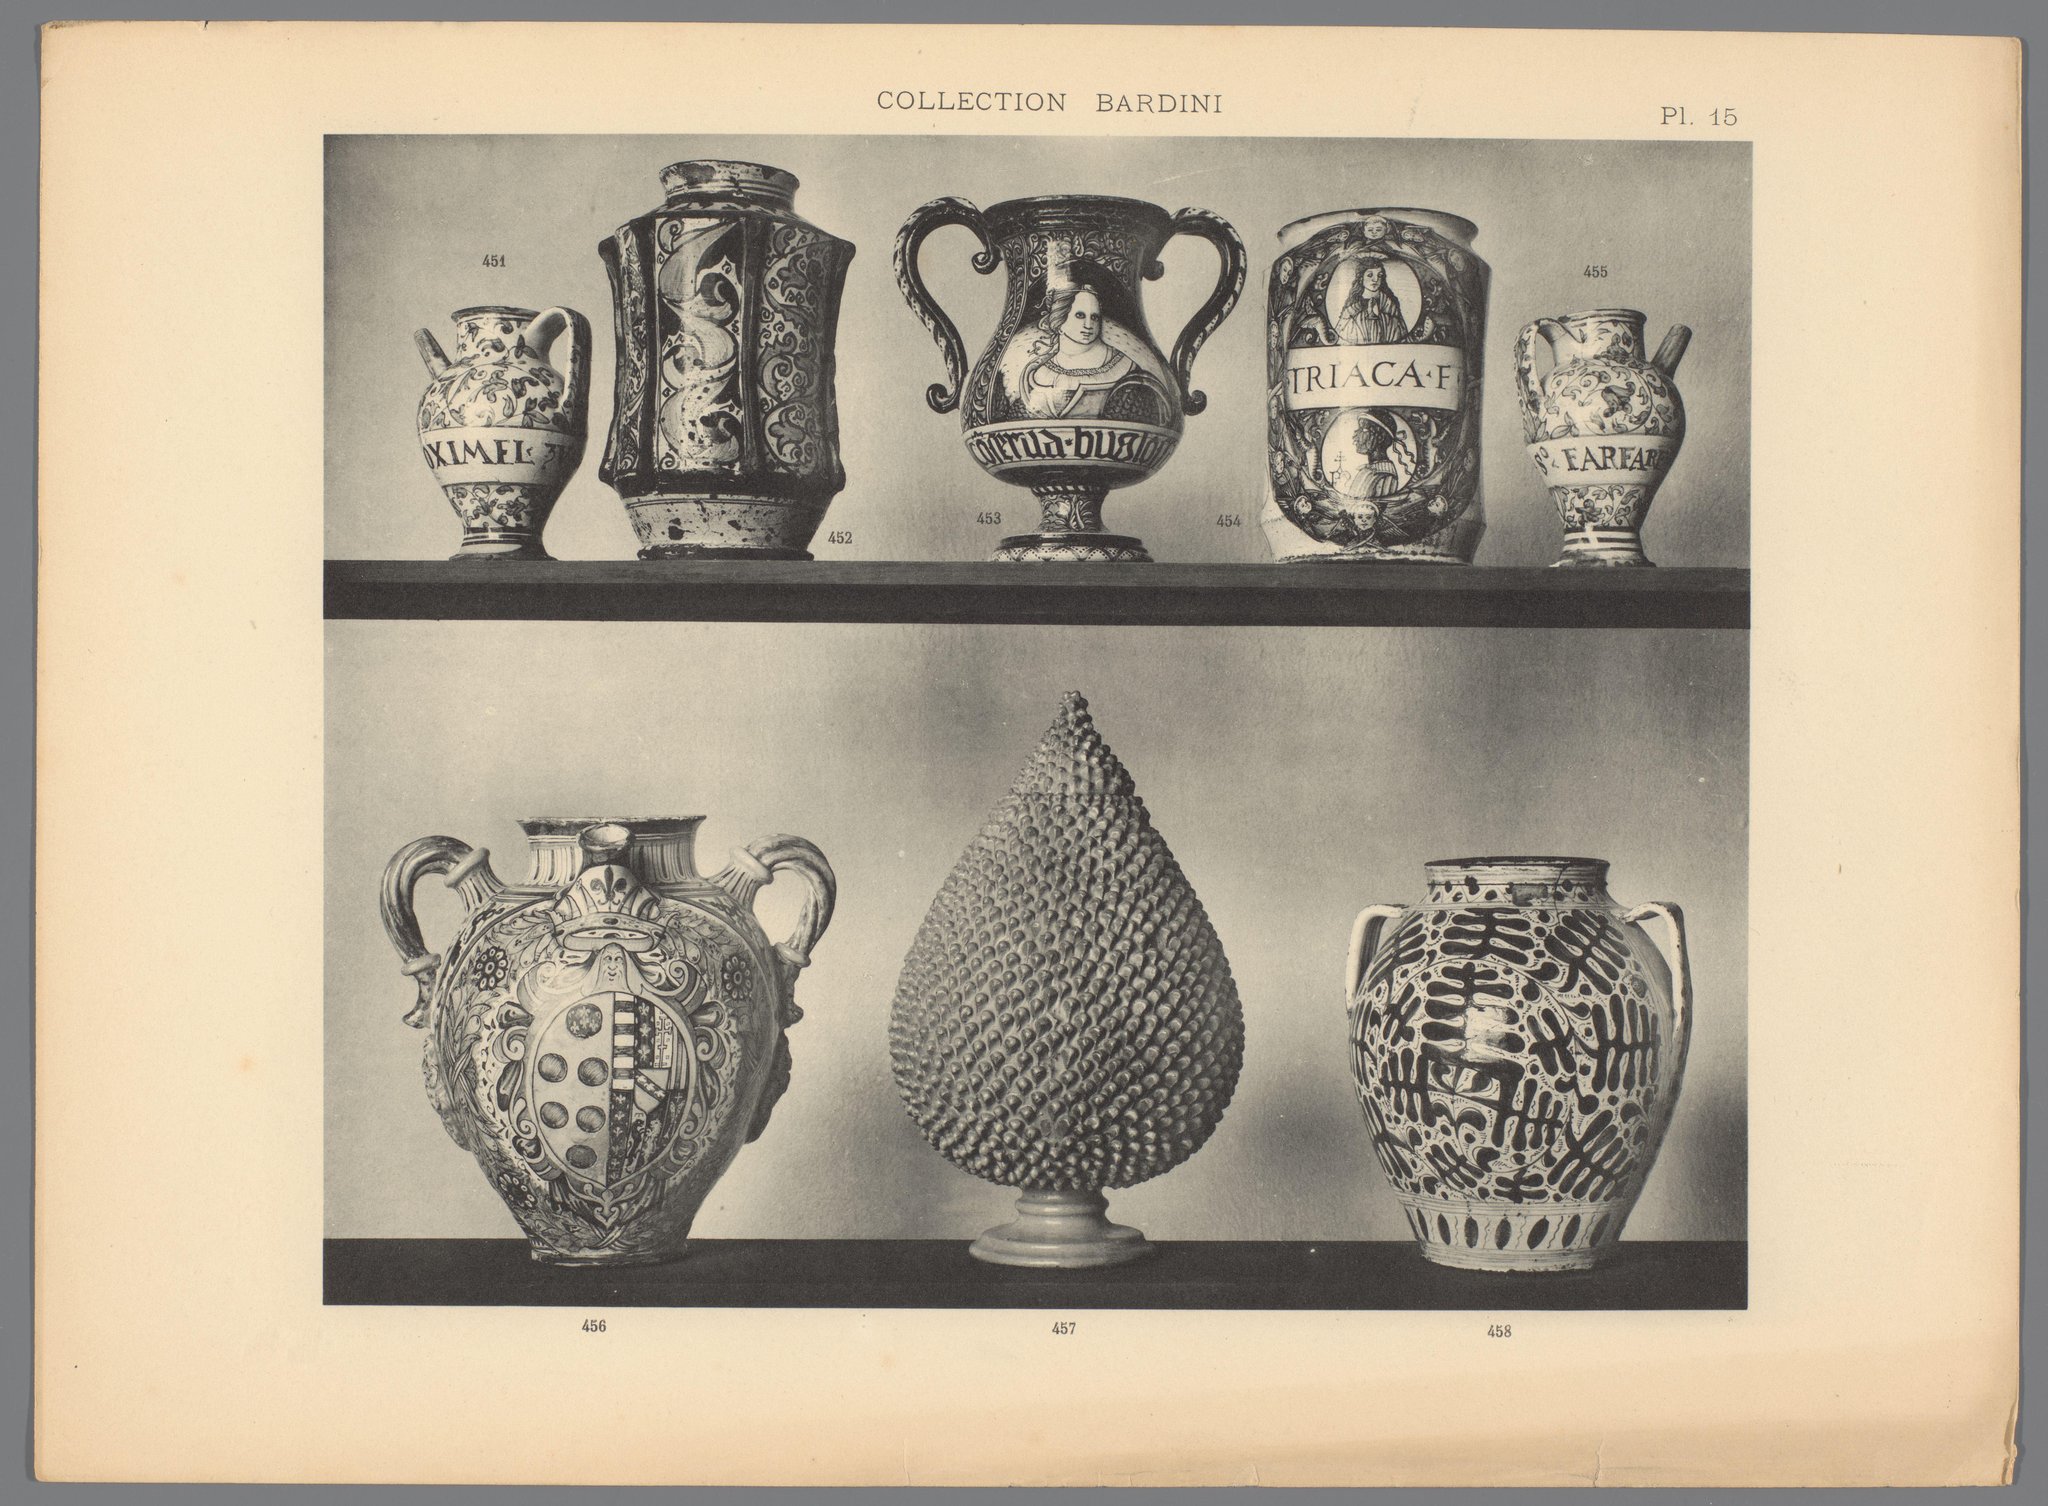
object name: photomechanical print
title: Verzameling gedecoreerde vazen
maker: Anonymous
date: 1875-1930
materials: paper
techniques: photograph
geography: florence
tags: container of ceramics: jar, jug, pot, vase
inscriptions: number: ‘Pl. 15’